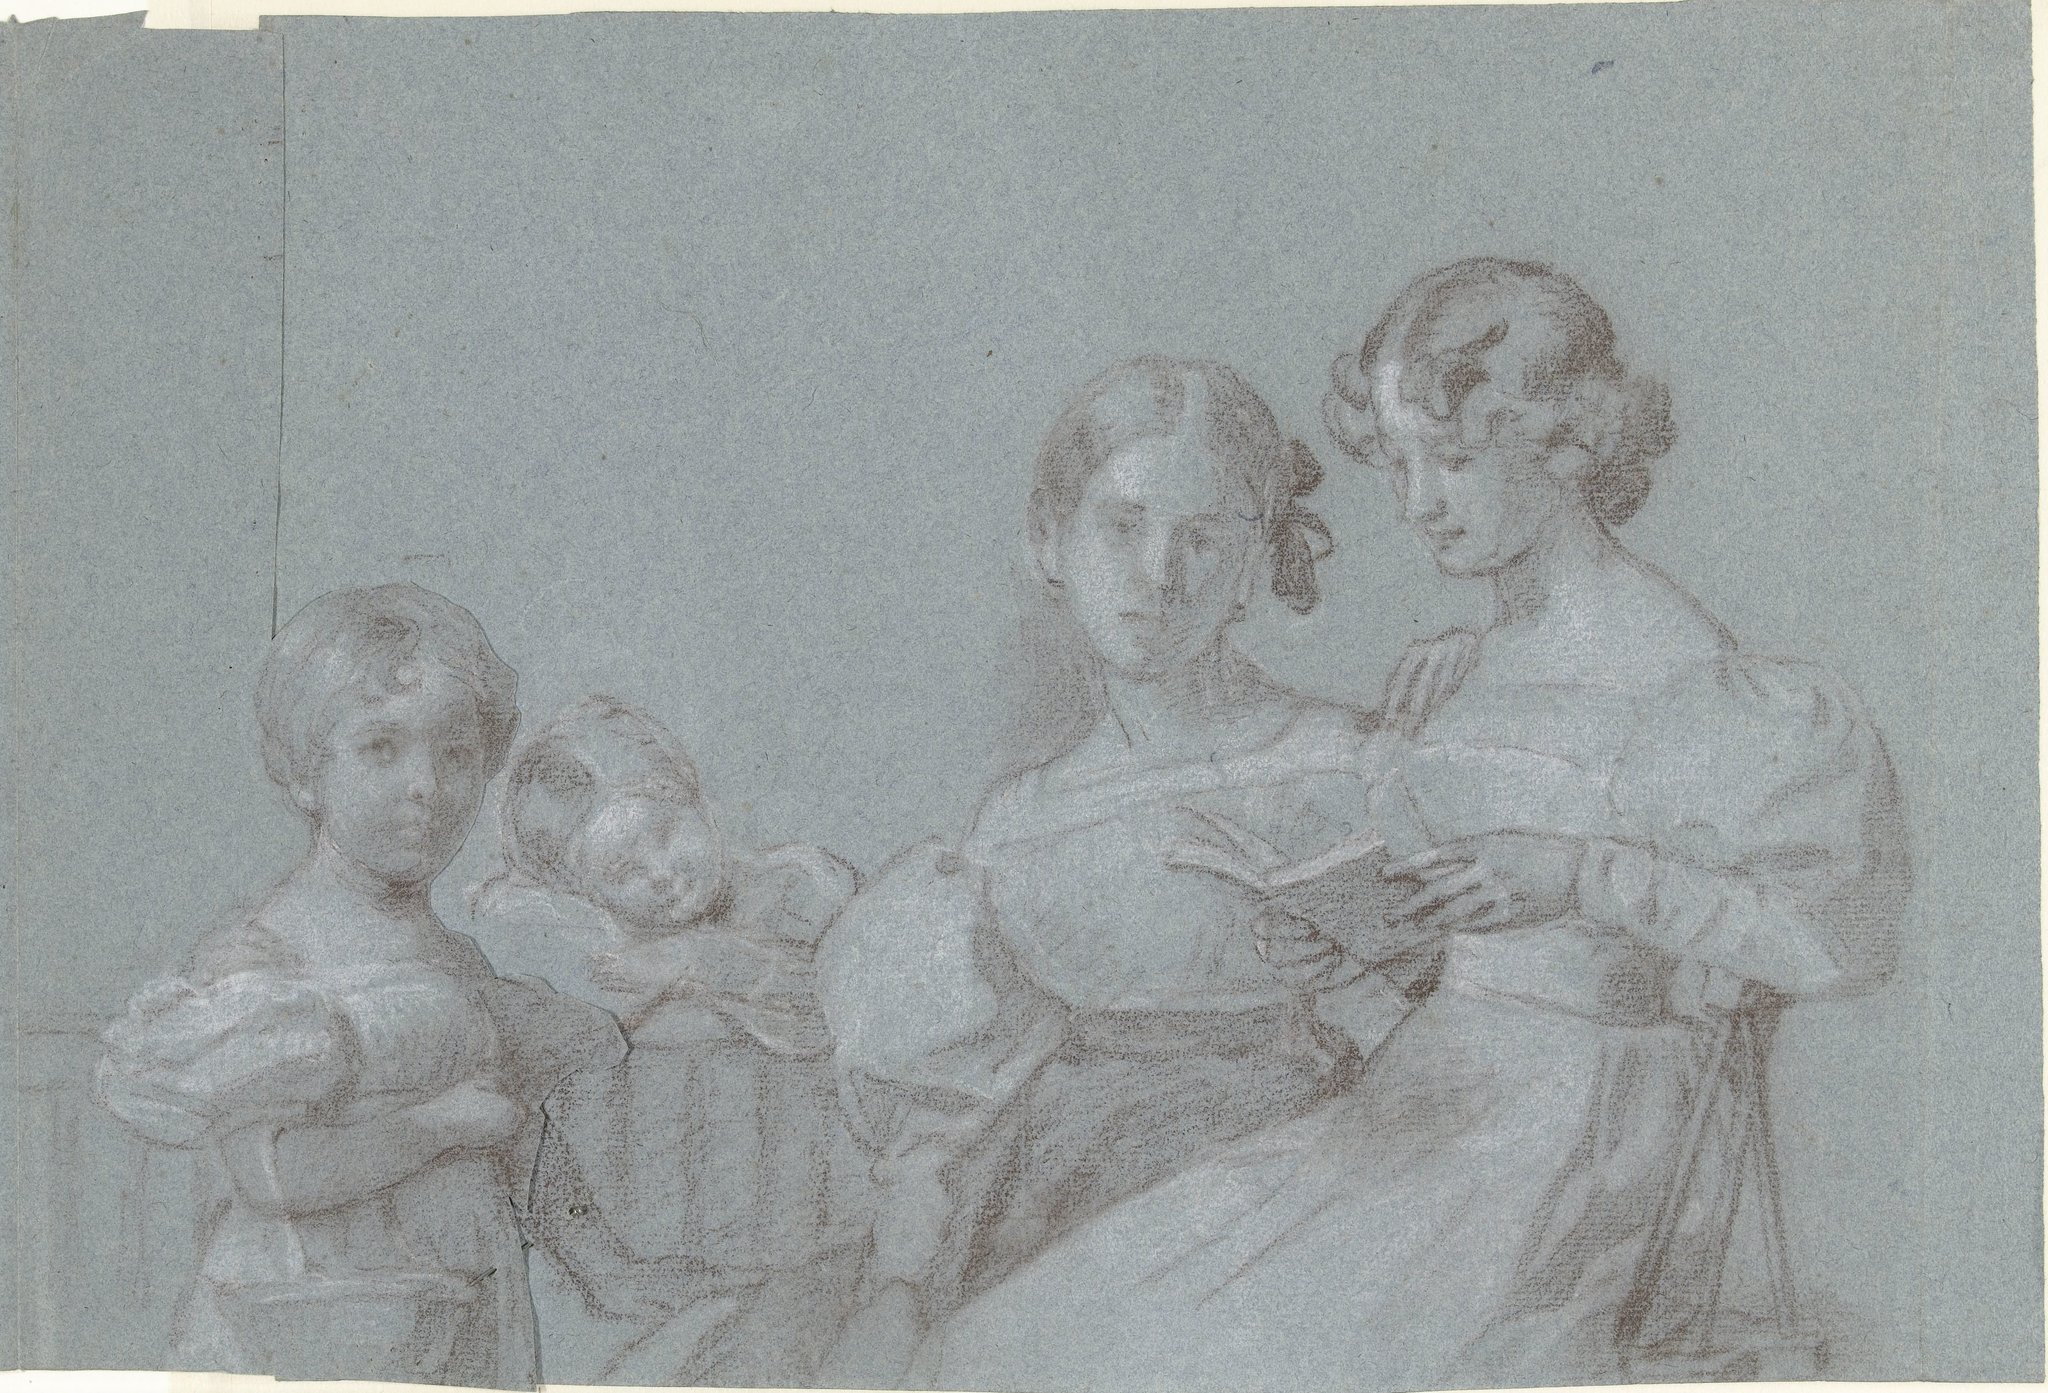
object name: drawing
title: Portret van de vier zusjes Van Loon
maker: charles howard hodges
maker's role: draughtsman, painter, print maker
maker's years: 1764-1837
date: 1774-1837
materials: chalk, paper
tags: historical persons